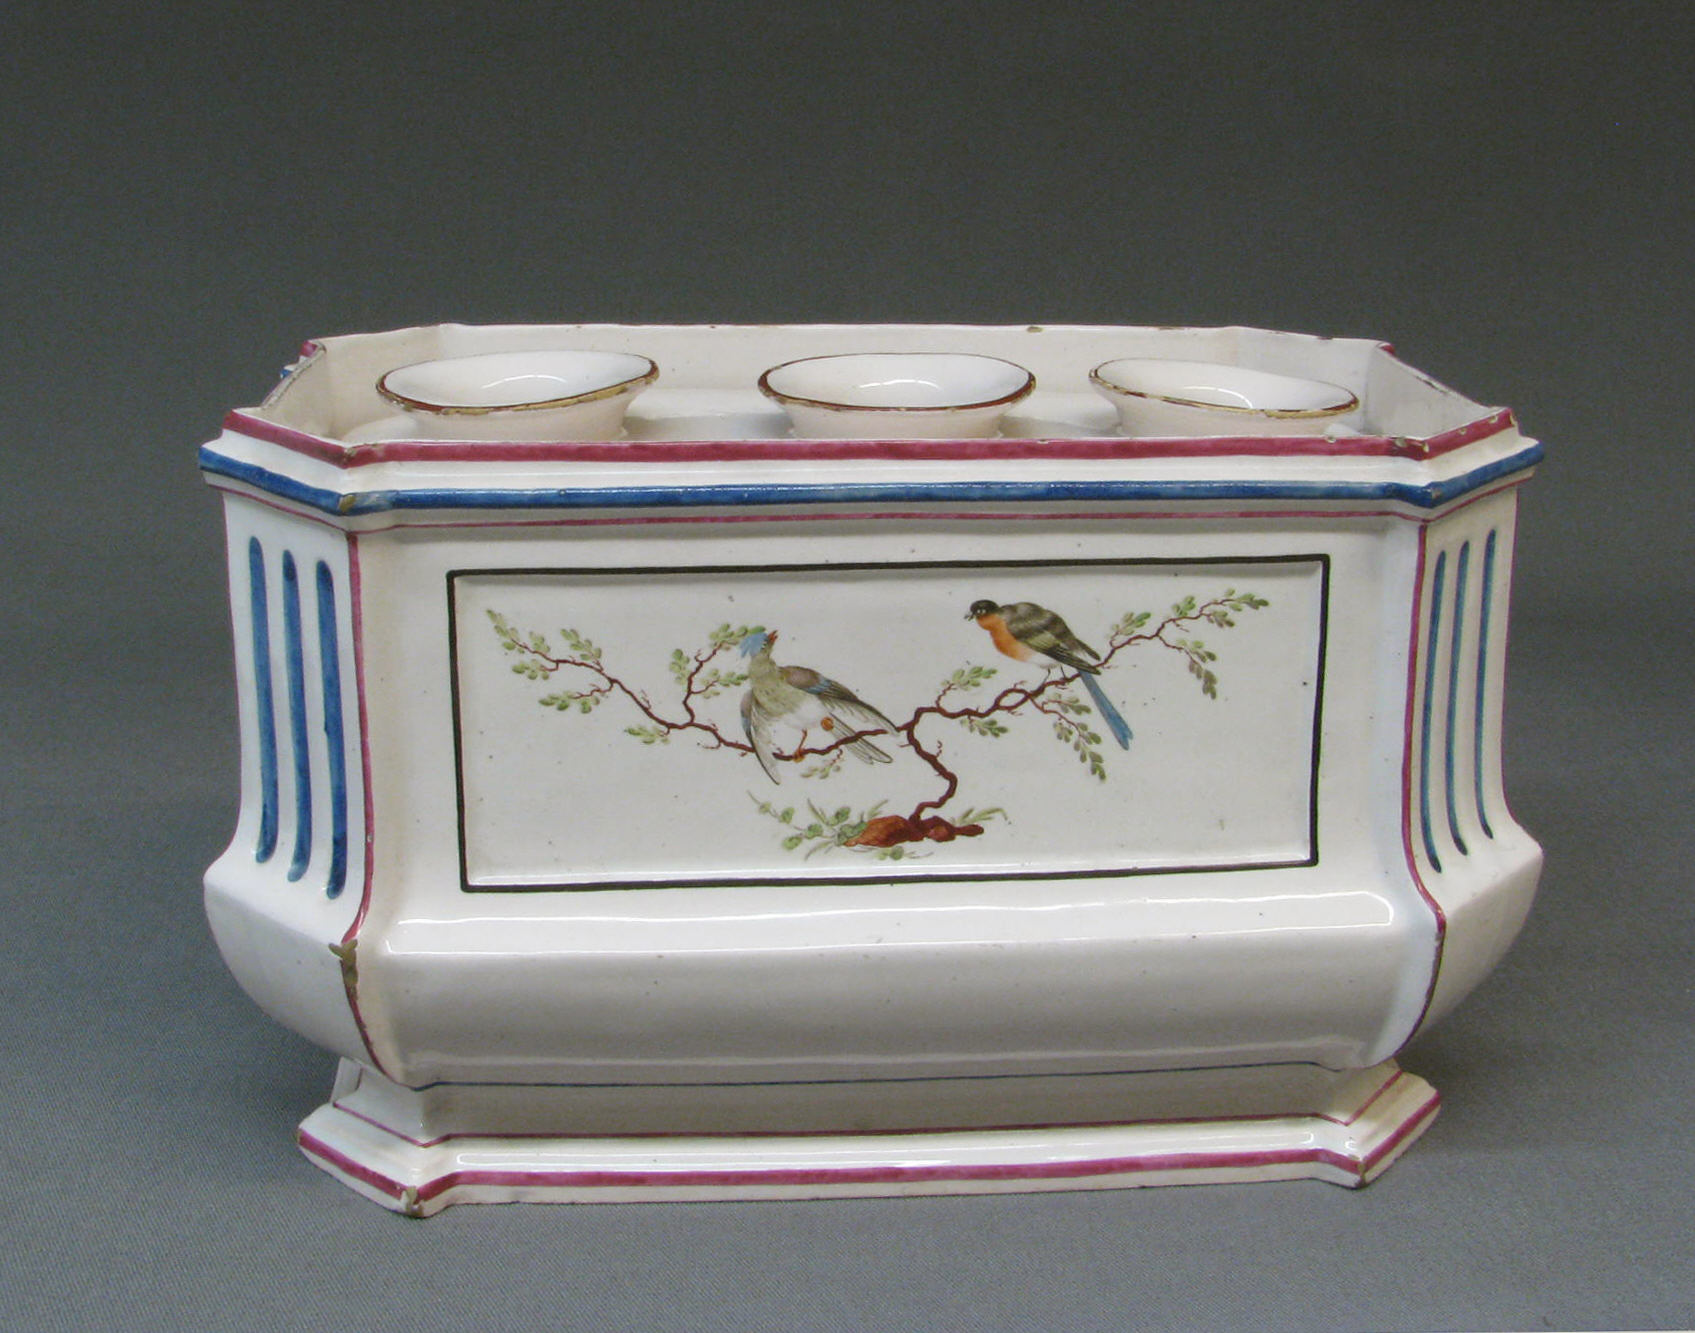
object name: jardinière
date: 1750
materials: faience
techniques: glazing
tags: birds,trees